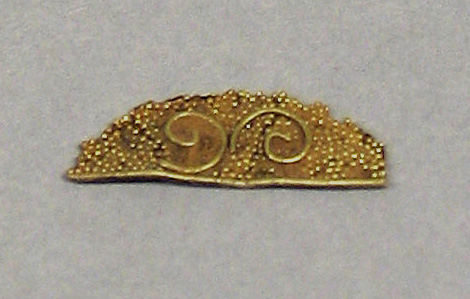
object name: ornament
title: Ornaments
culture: chinese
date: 618-907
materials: gold